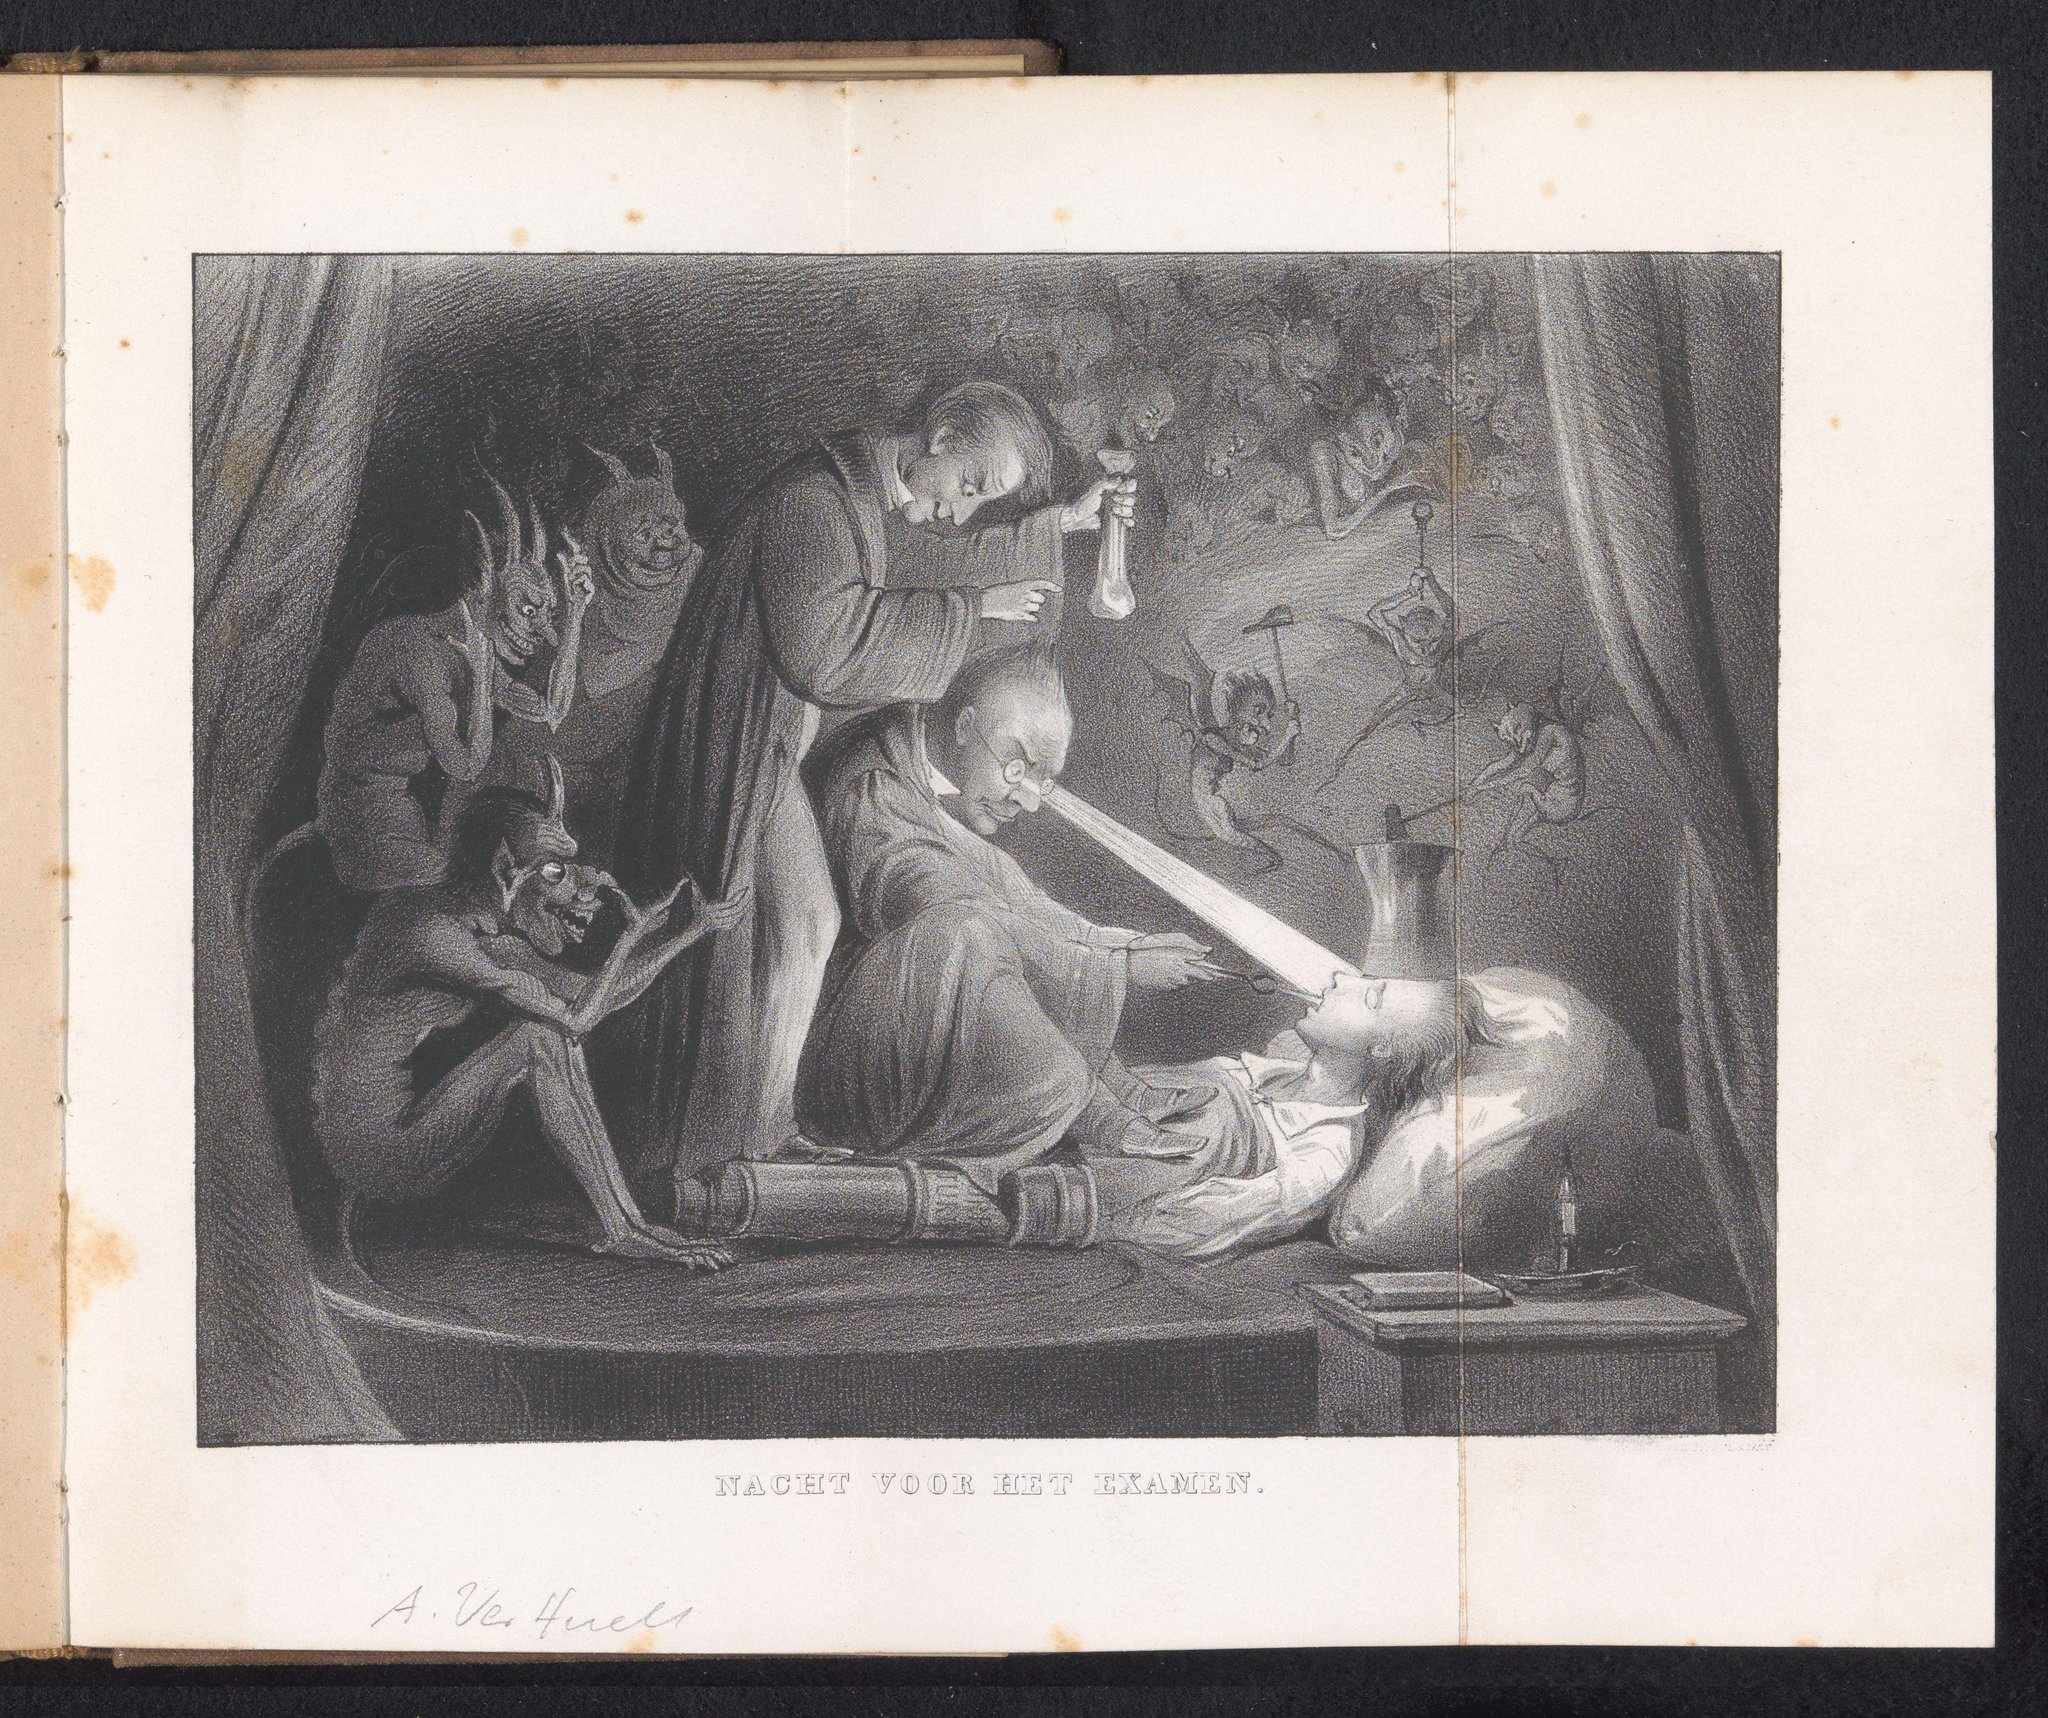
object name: cartoon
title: Nacht voor het examen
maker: Anonymous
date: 1844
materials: paper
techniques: lithograph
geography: netherlands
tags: nightmare, examination ~ university, activities of devil(s), student life, leiden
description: Slapende student in de nacht voor het examen lastig gevallen door figuren uit een nachtmerrie. Professor C.J. van Assen schijnt met een licht in het gezicht van de student, achter hem de pedel en lachende duivels. Spotprent in de studentenalmanak van de Universiteit van Leiden van het jaar 1844.